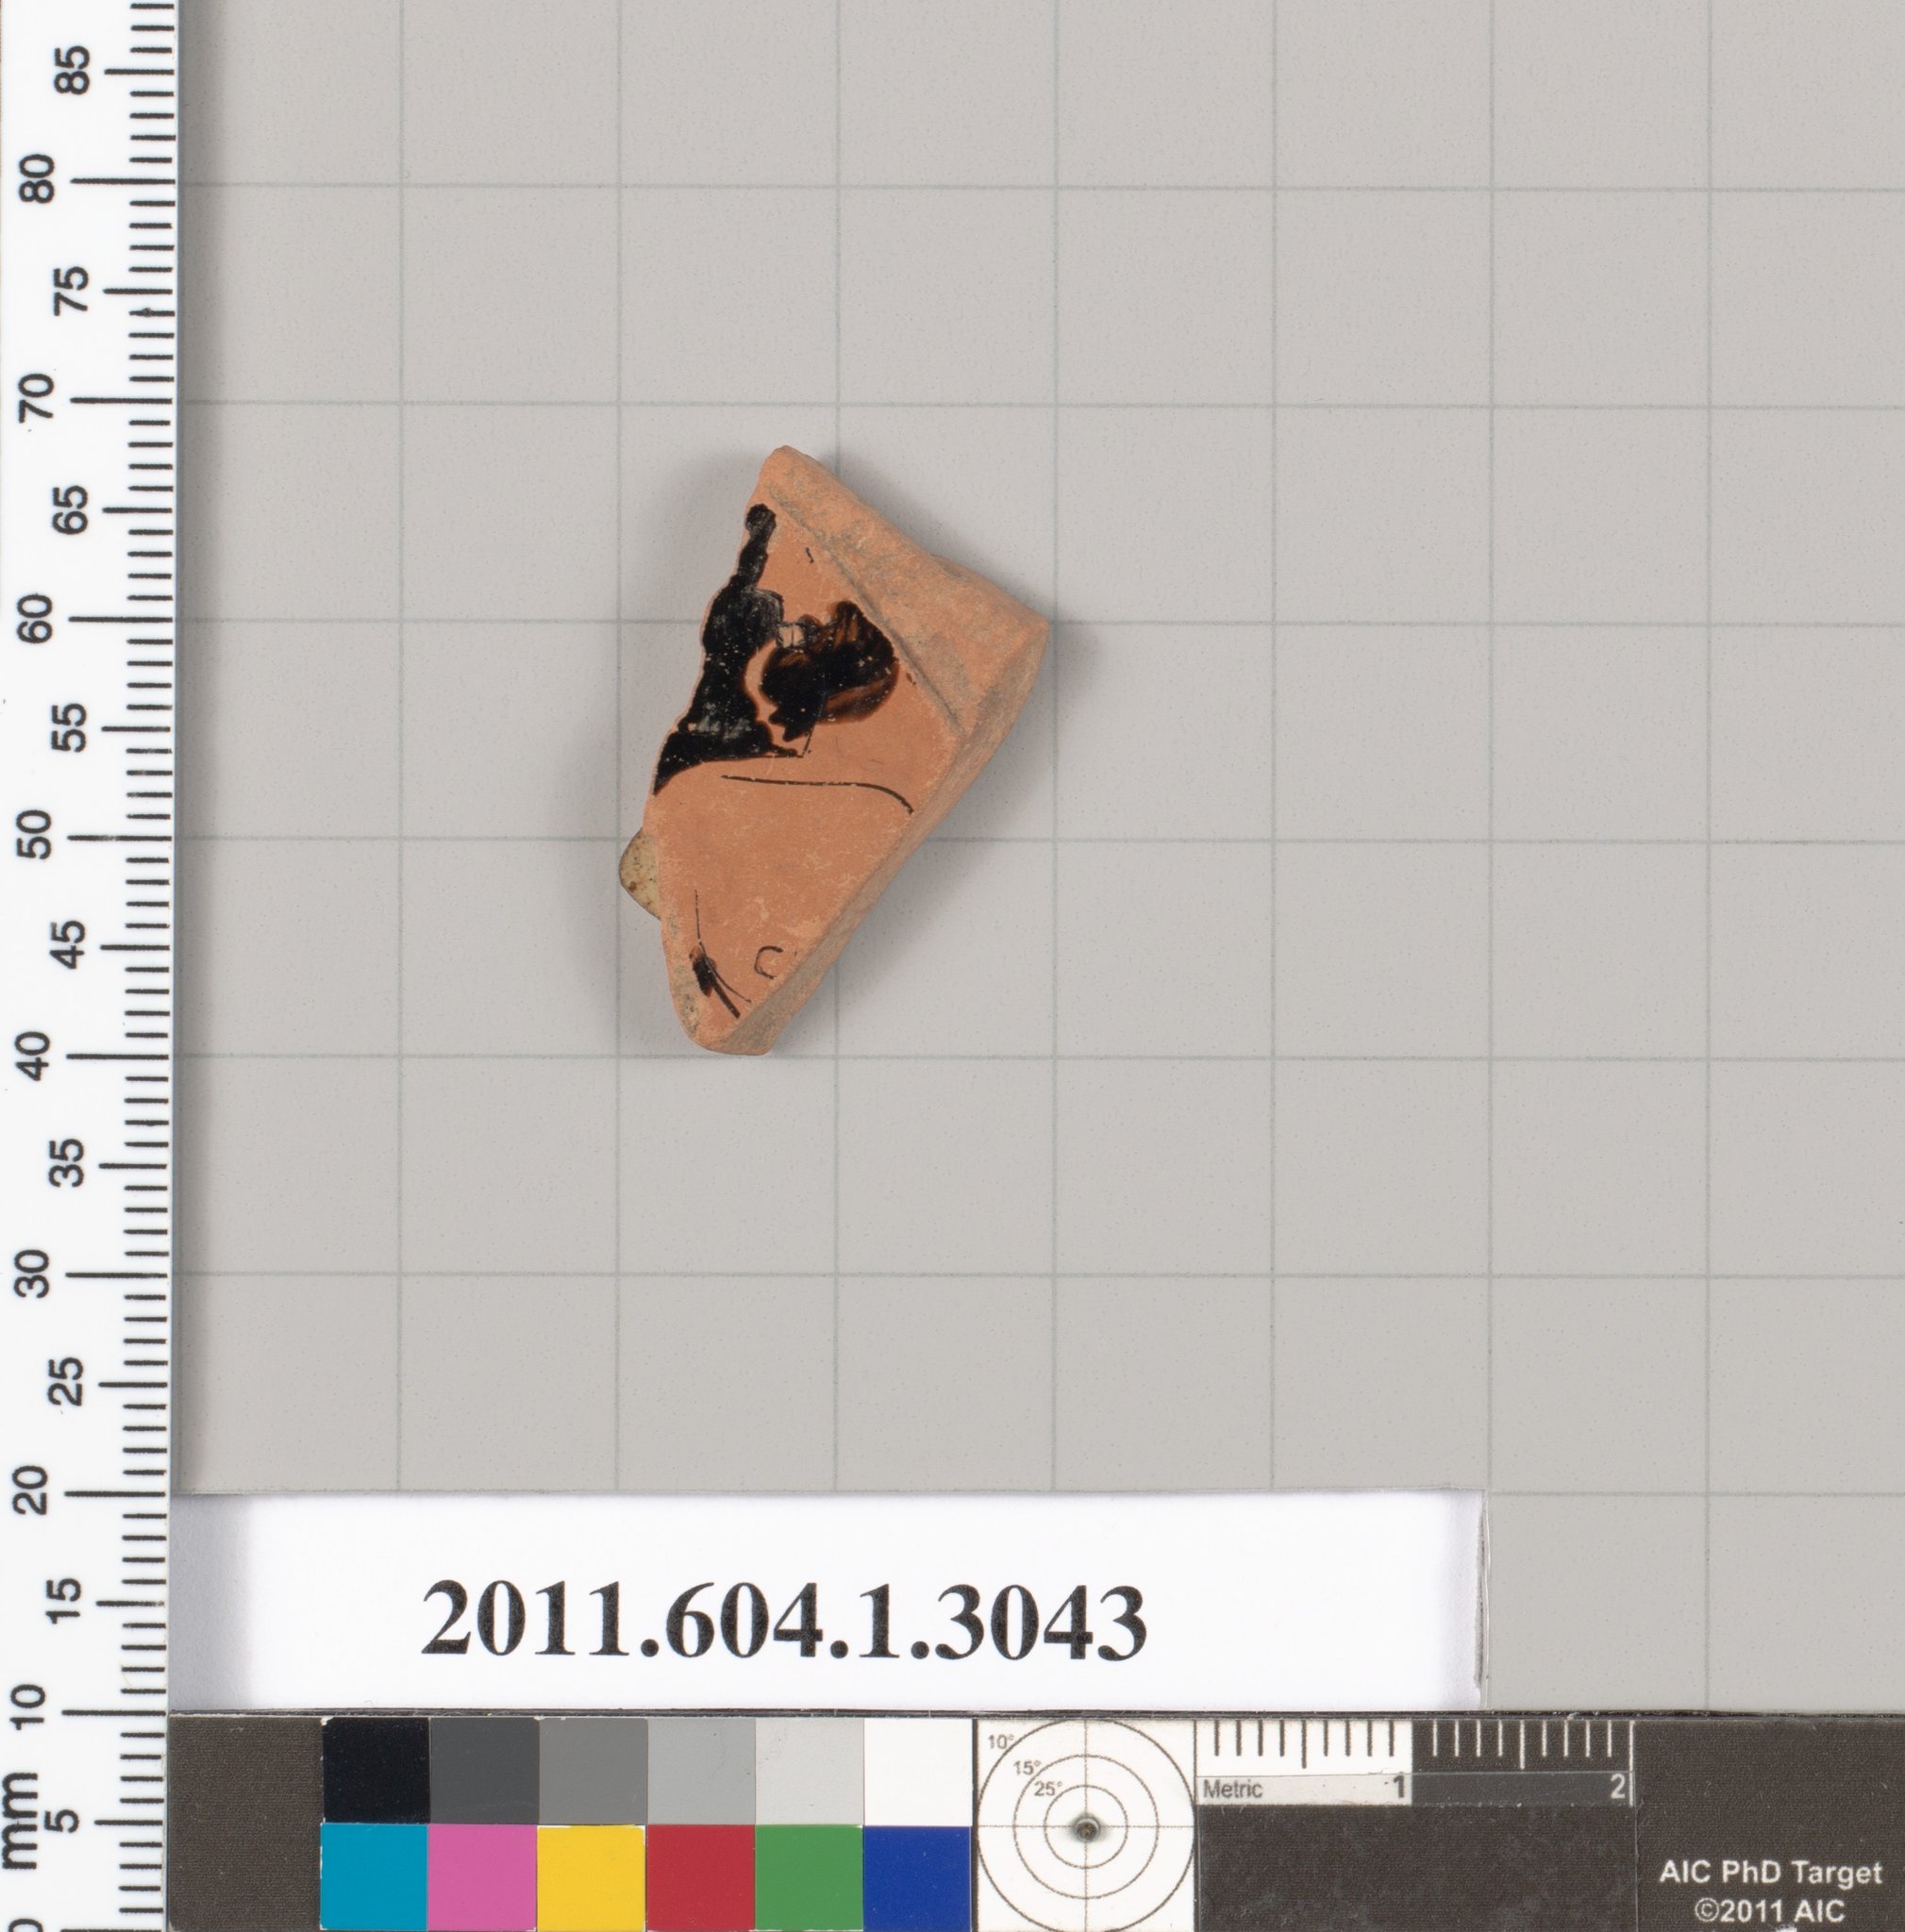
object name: kylix fragment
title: Terracotta fragment of a kylix (drinking cup)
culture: greek, attic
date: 470-460 BCE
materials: terracotta